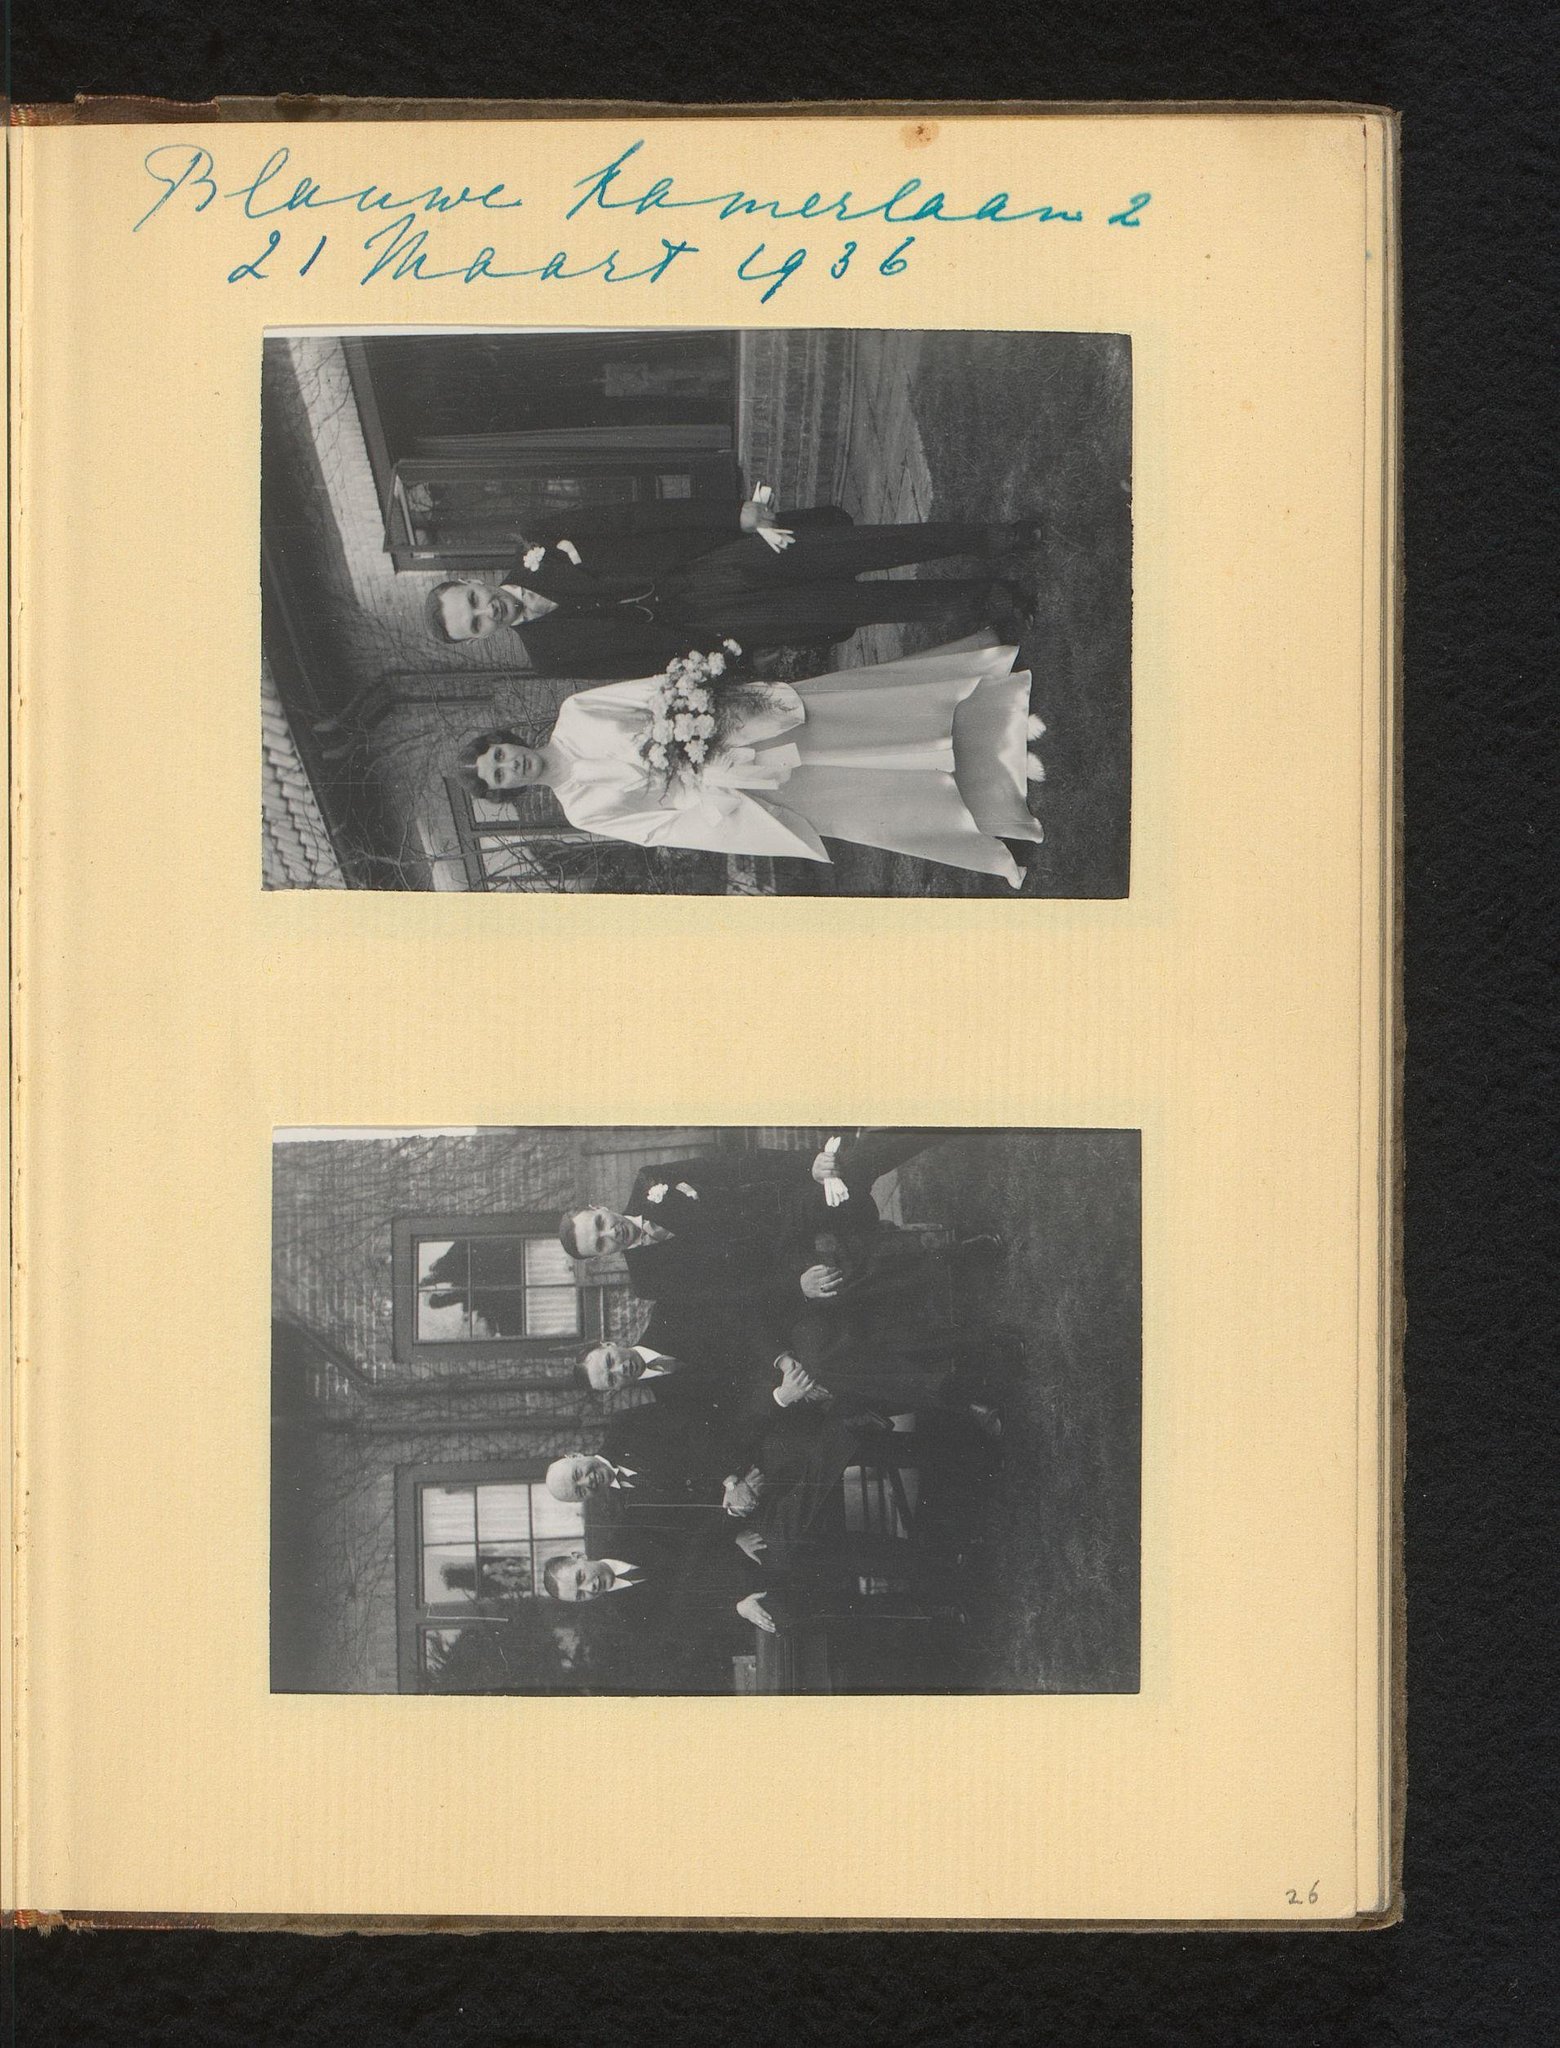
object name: photograph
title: Receptie Blauwe Kamerlaan 2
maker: Anonymous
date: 1936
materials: paper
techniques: gelatin silver print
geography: the hague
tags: rotterdam, dirk hudig (1876-1973), amsterdam, members of bridal party, bride and groom in wedding-dress, father and son(s) (family group), the hague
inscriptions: inscription: ‘Receptie Blauwe Kamerlaan 2/ 21 Maart 1936’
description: Deze foto's maken deel uit van een album.